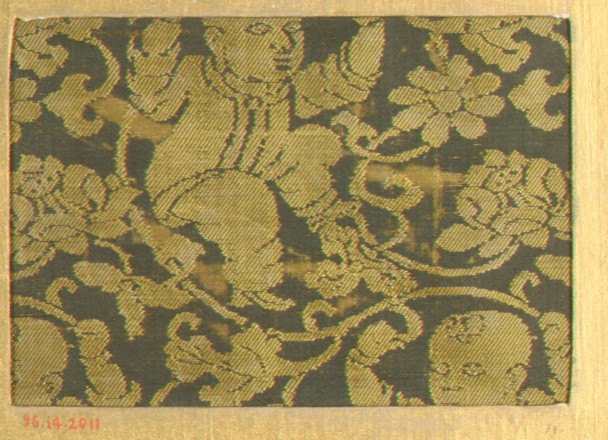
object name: piece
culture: japanese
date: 1701-1900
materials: silk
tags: flowers